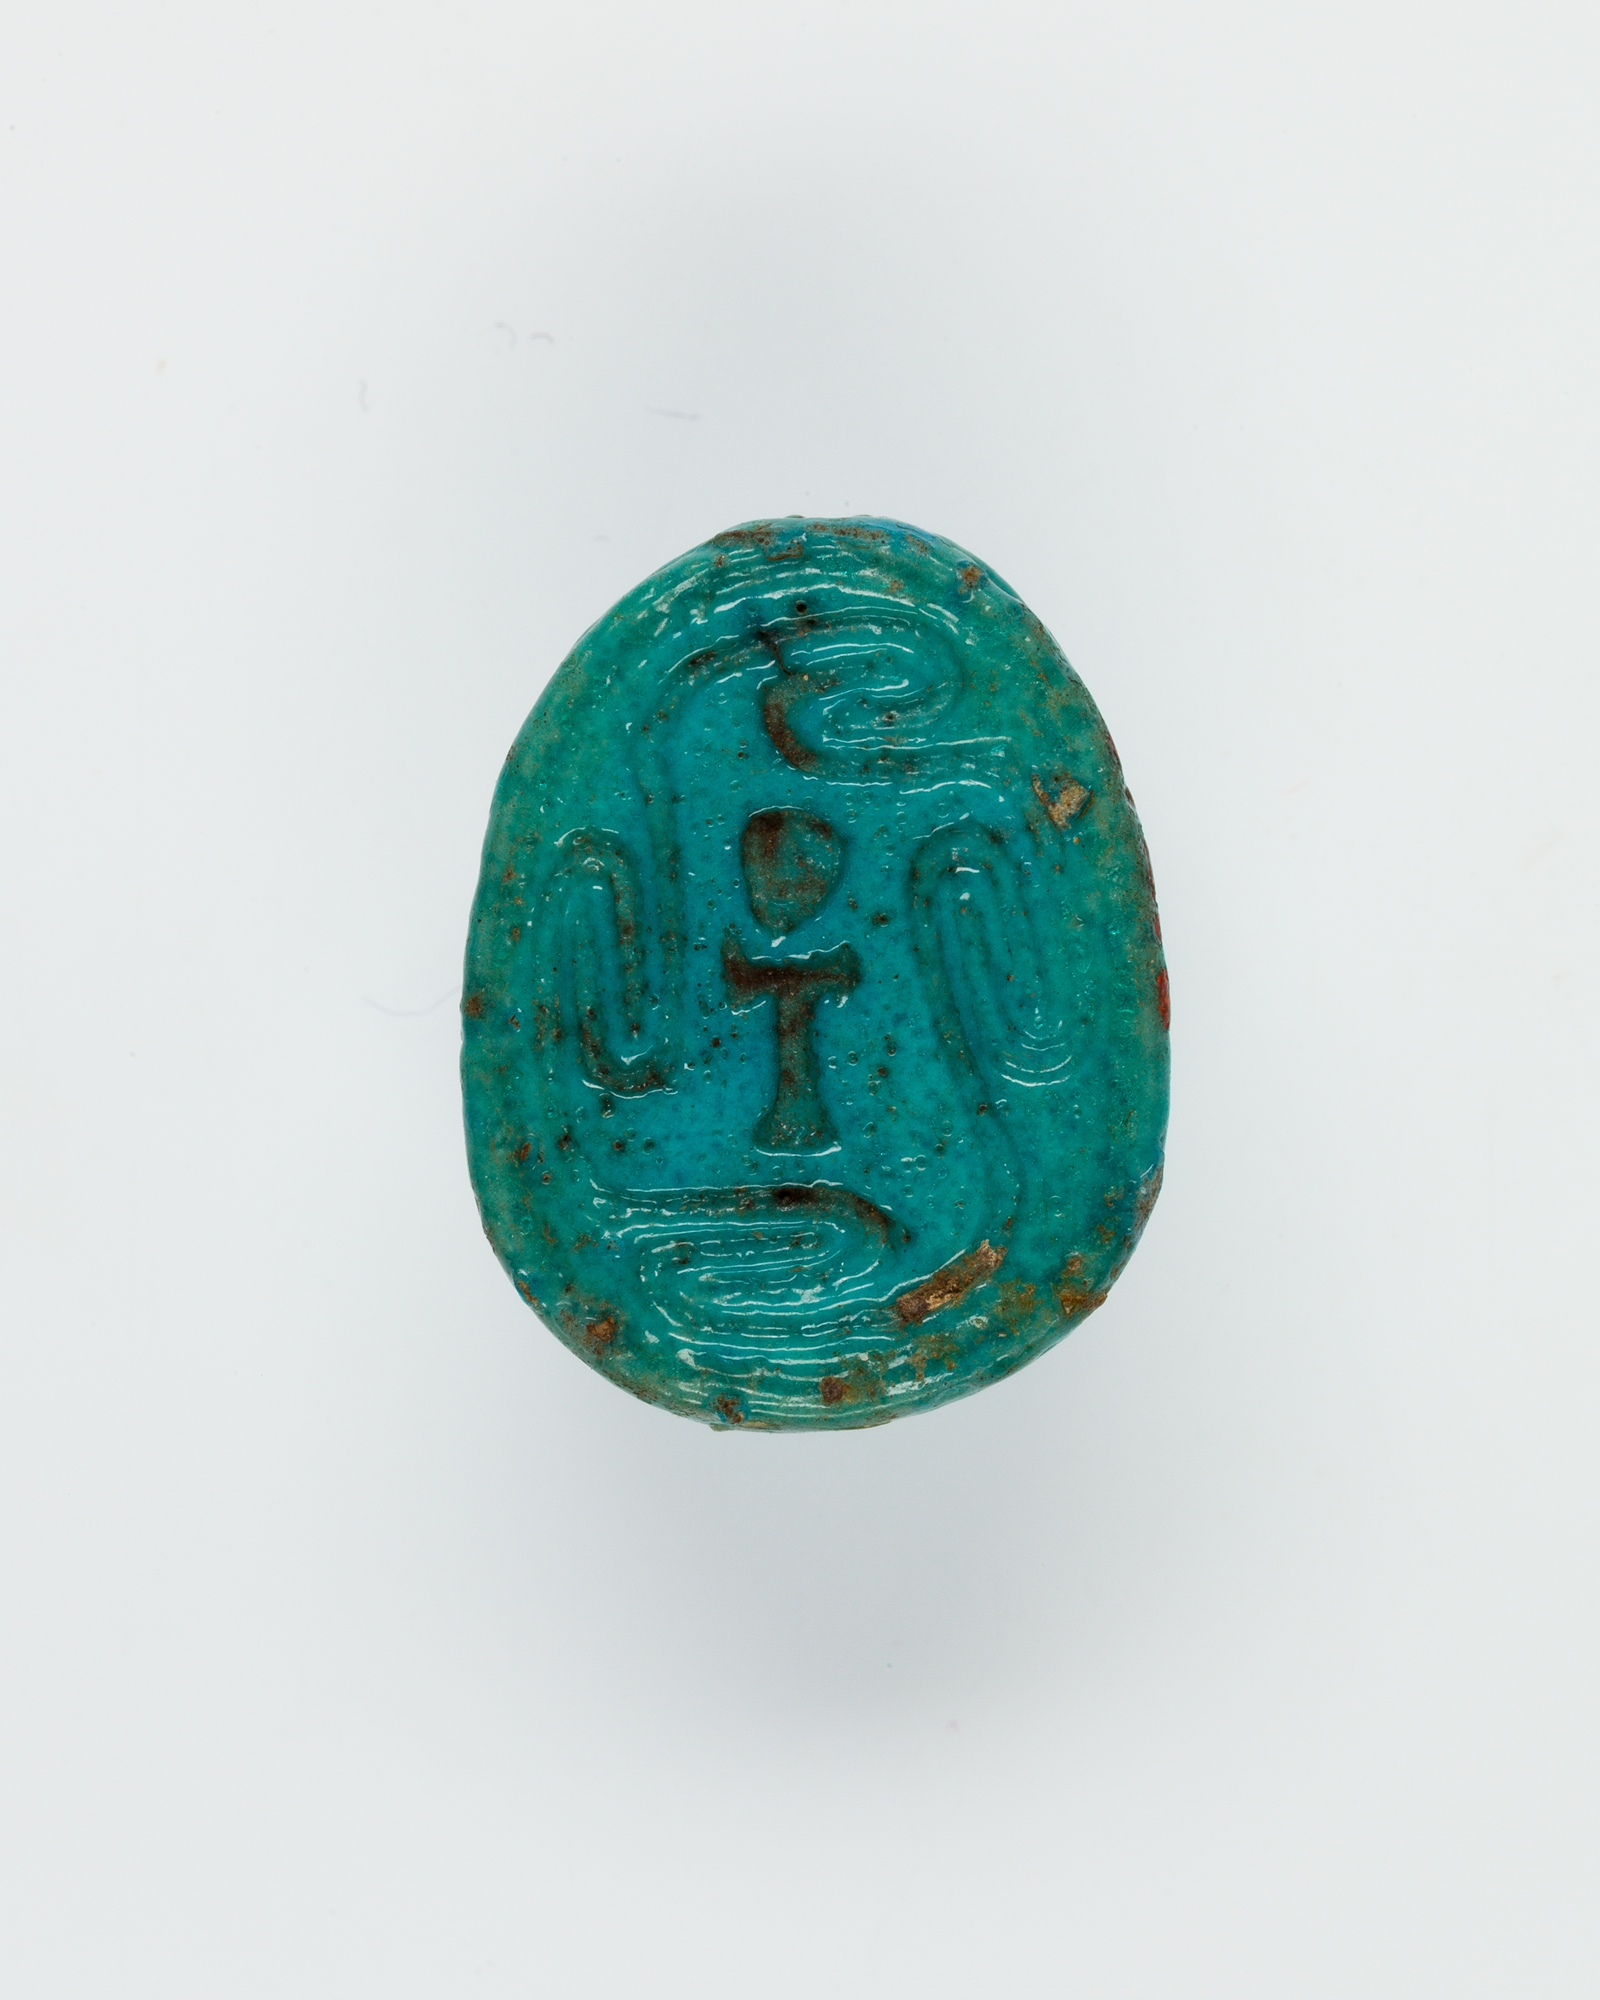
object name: scarab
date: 1492-1479 BCE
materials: faience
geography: egypt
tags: scarabs